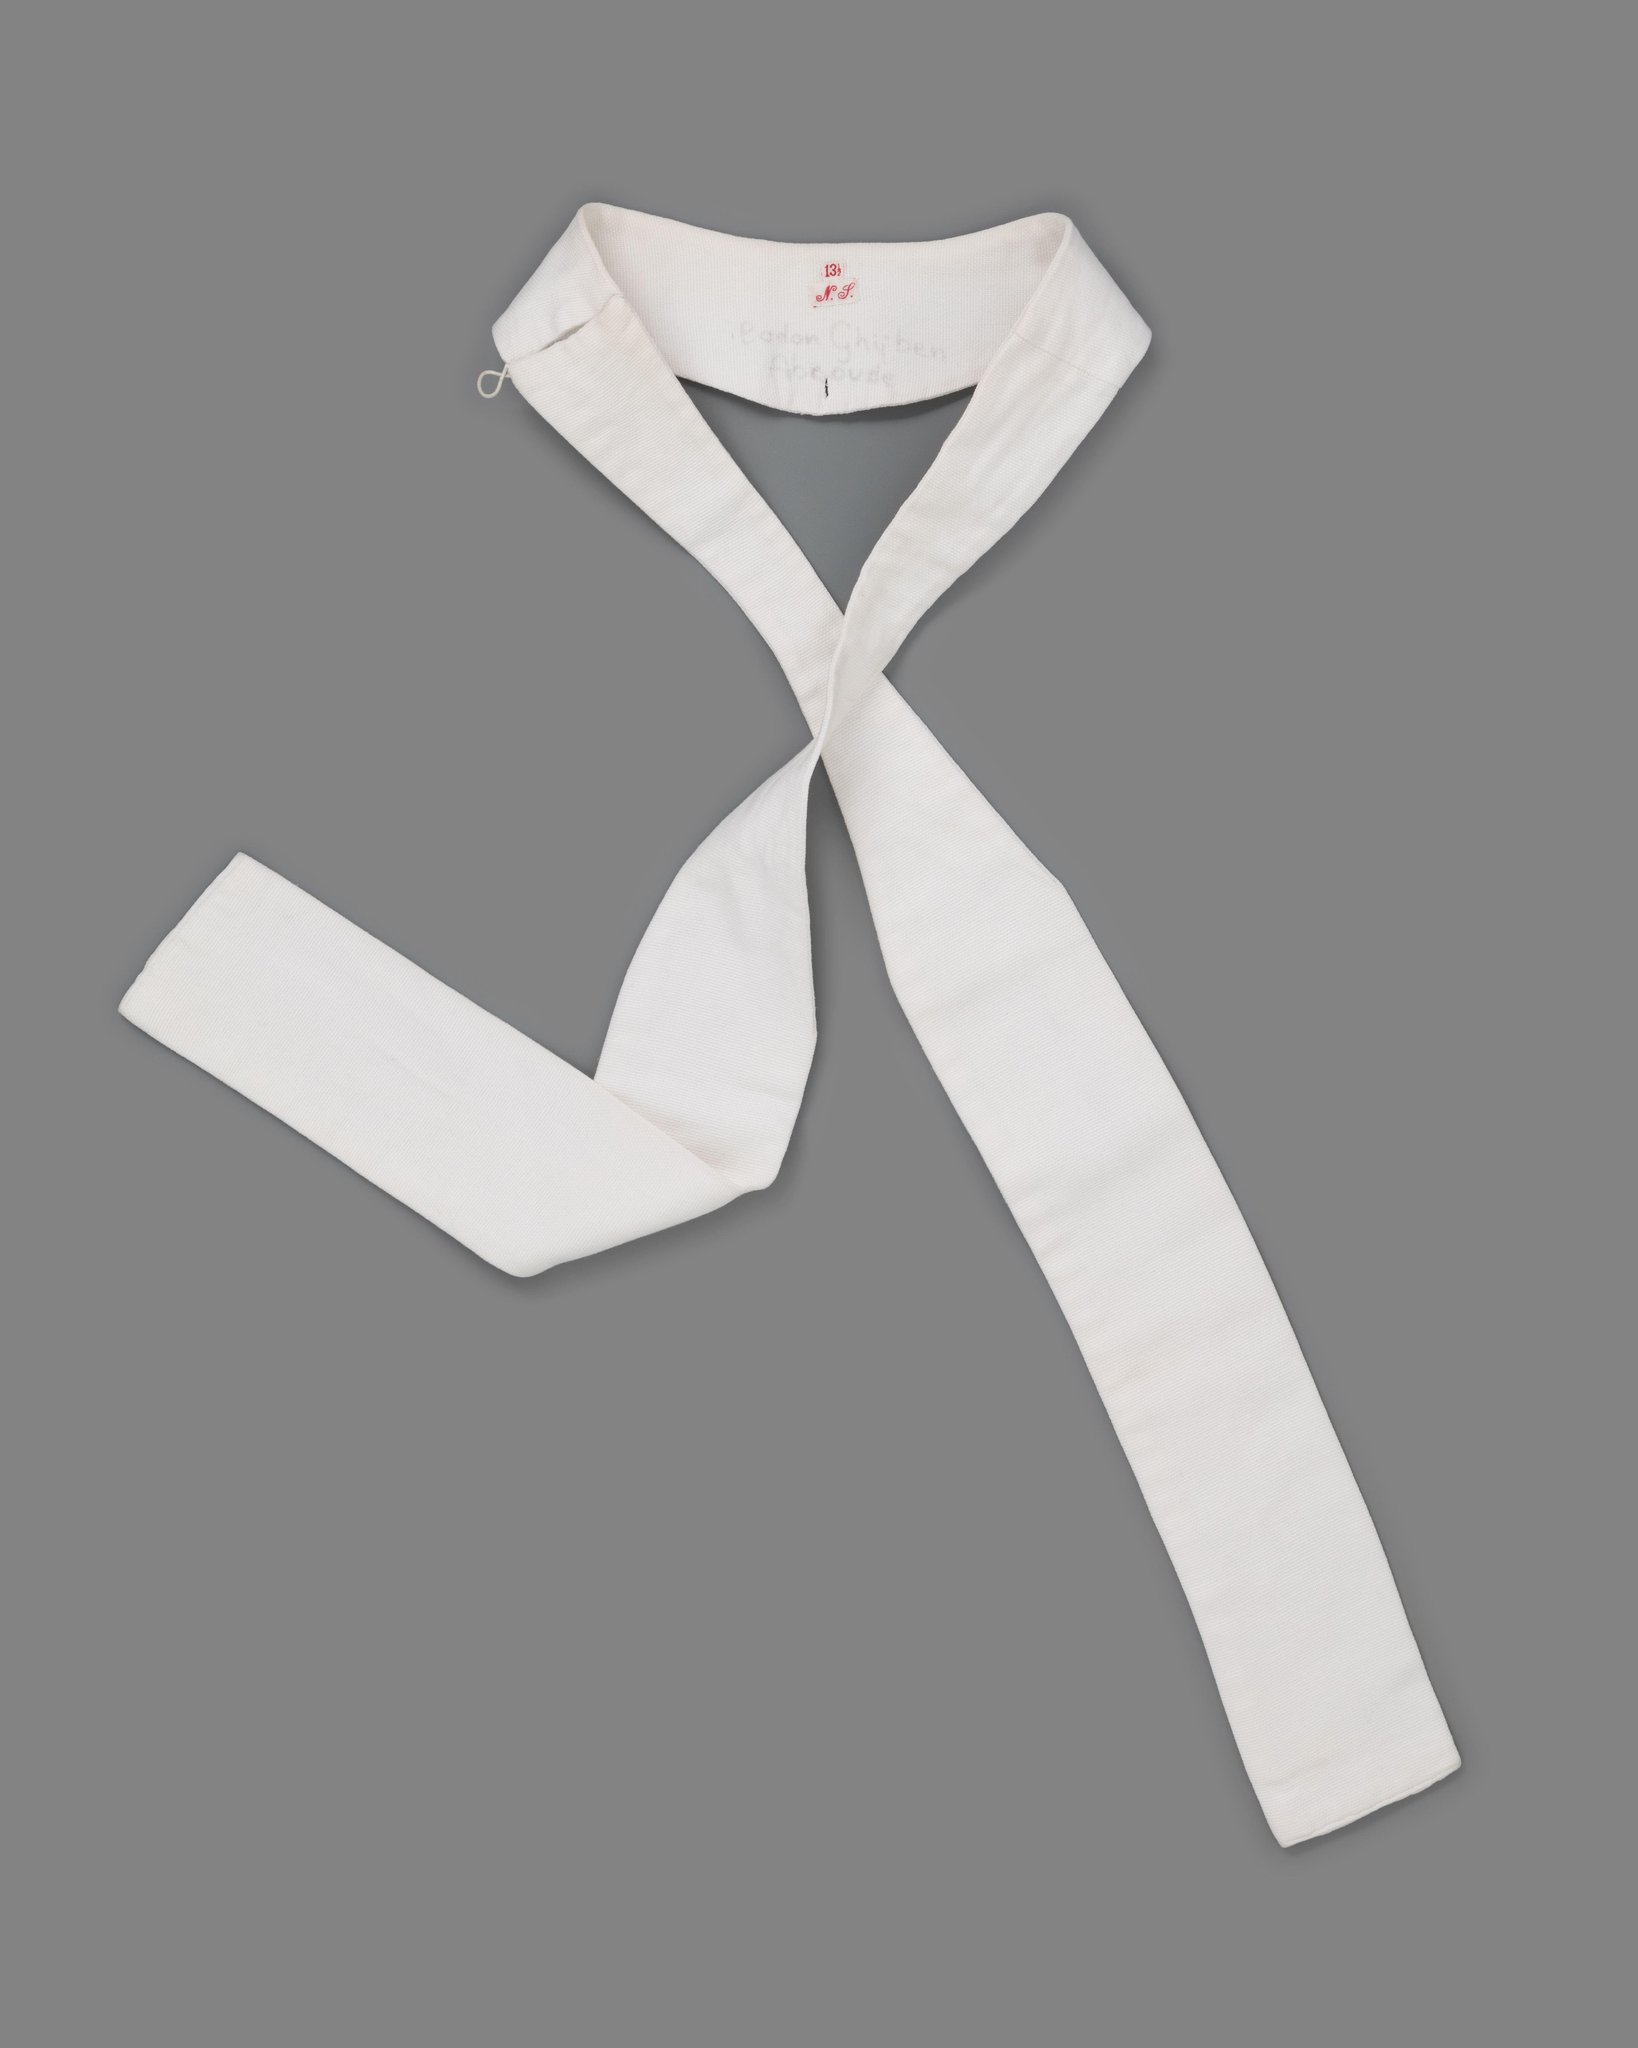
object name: rijkleding, paardrijkleding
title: Strikdas behorend bij een rijkostuum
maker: Anonymous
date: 1934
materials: cotton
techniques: weave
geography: netherlands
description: Strikdas van witte katoen in platbinding. Gemerkt met wit lint waarop in rode letters: '13 1/2' en 'NS'.